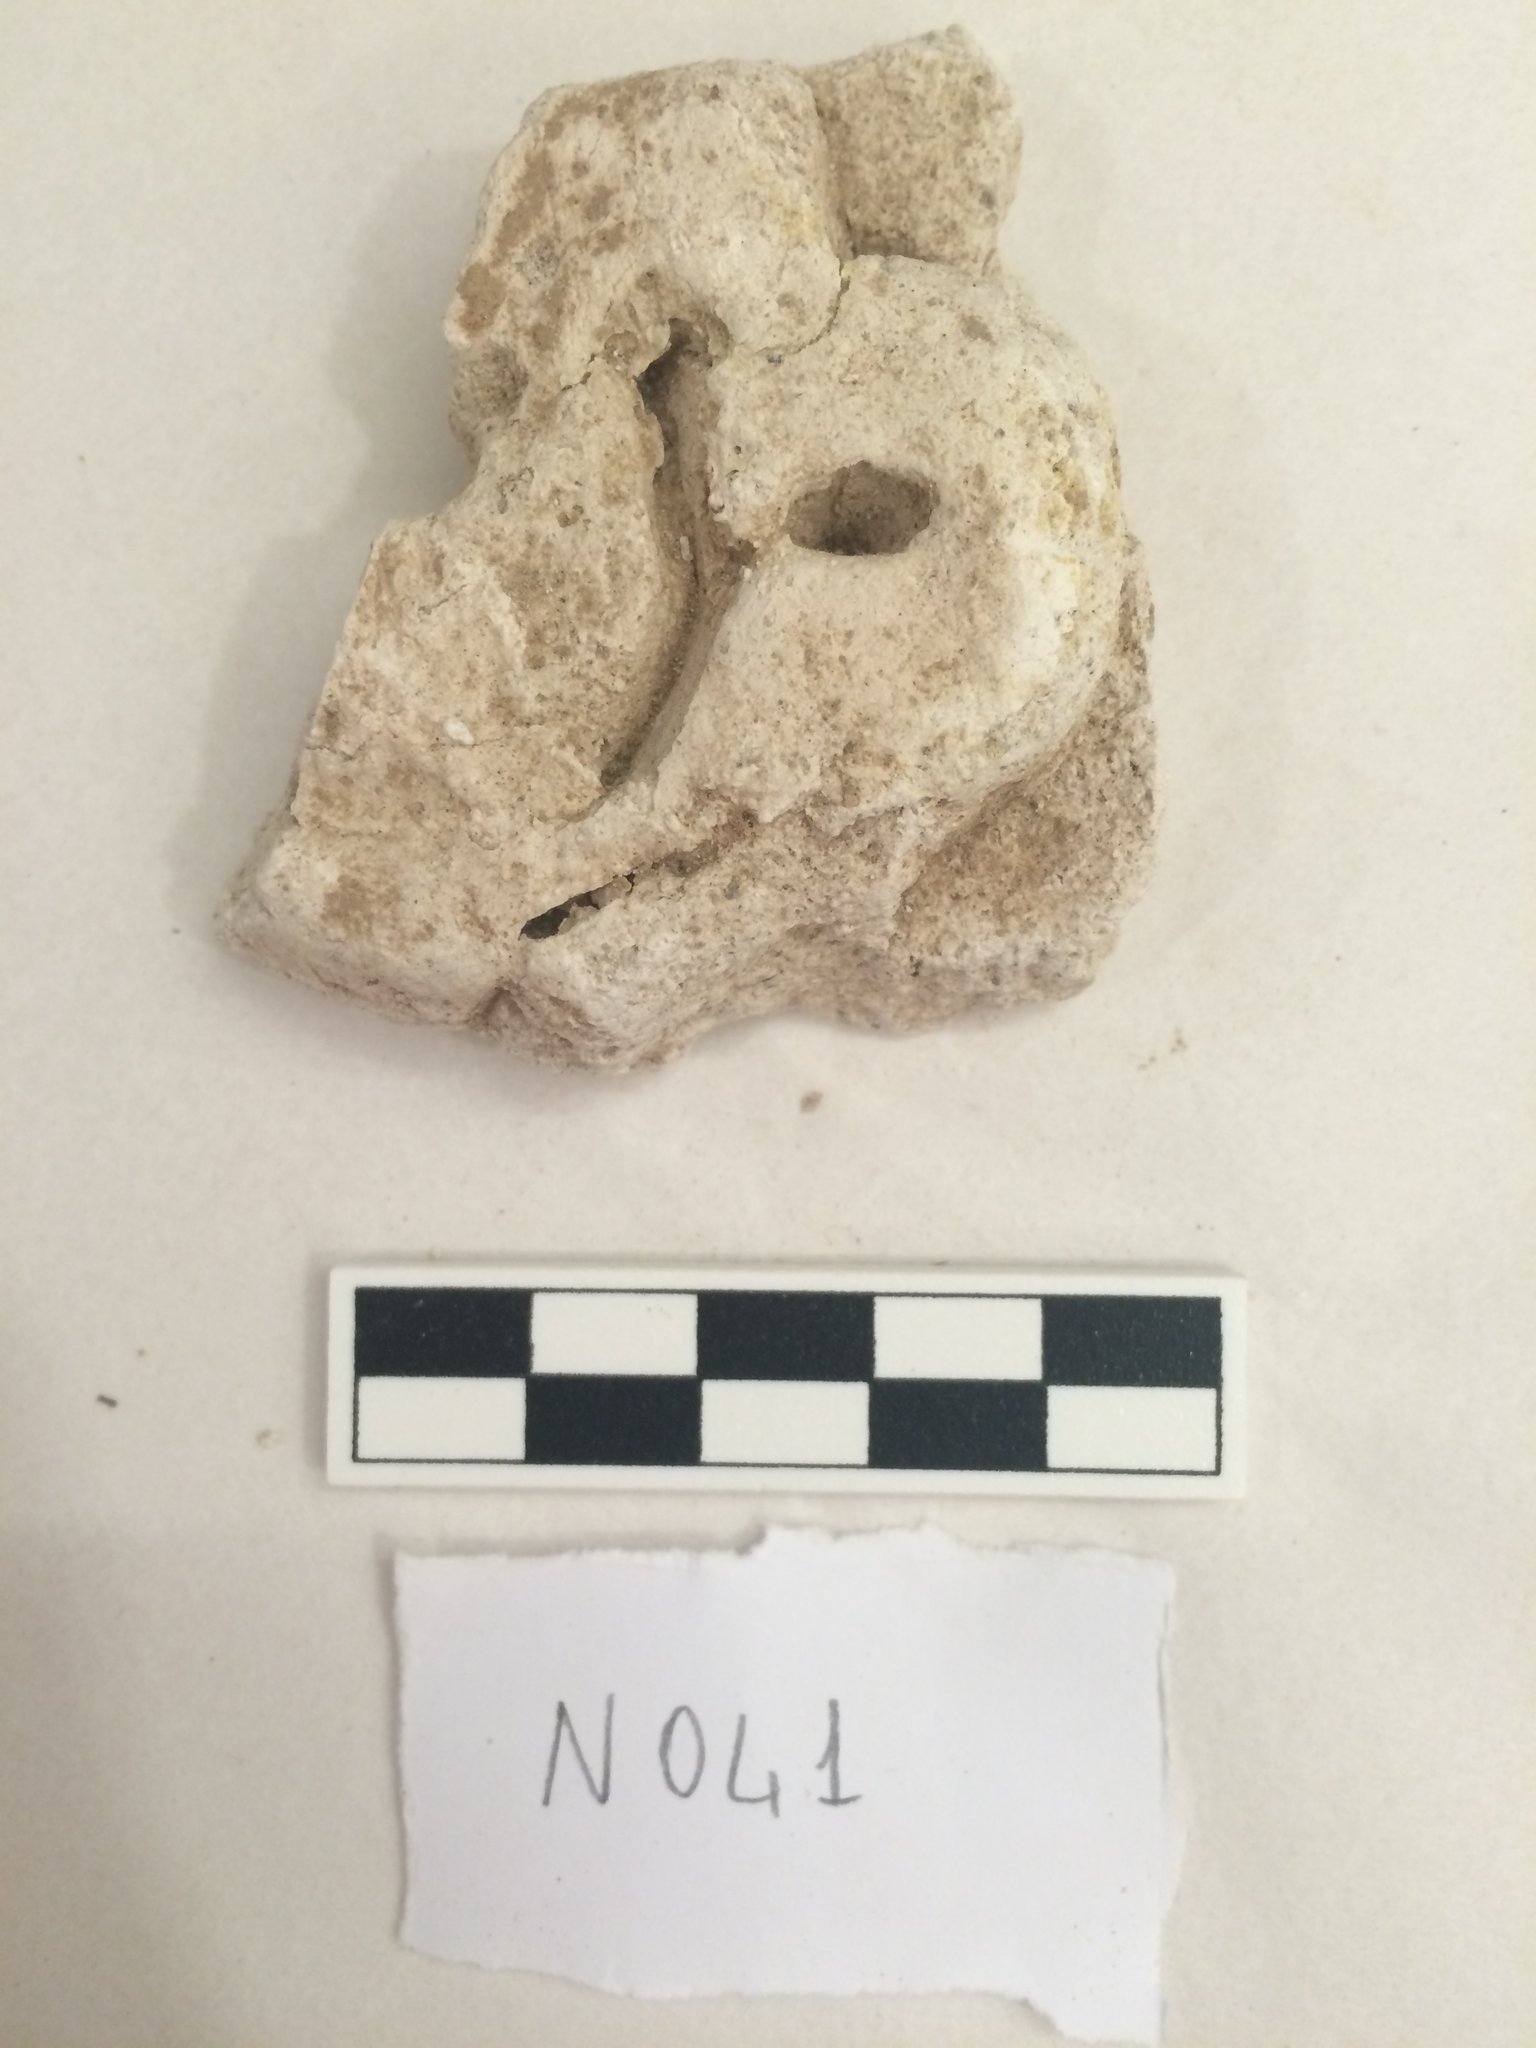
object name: fragment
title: Stucco Fragment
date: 701-1200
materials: plaster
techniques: carving, painting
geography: iran